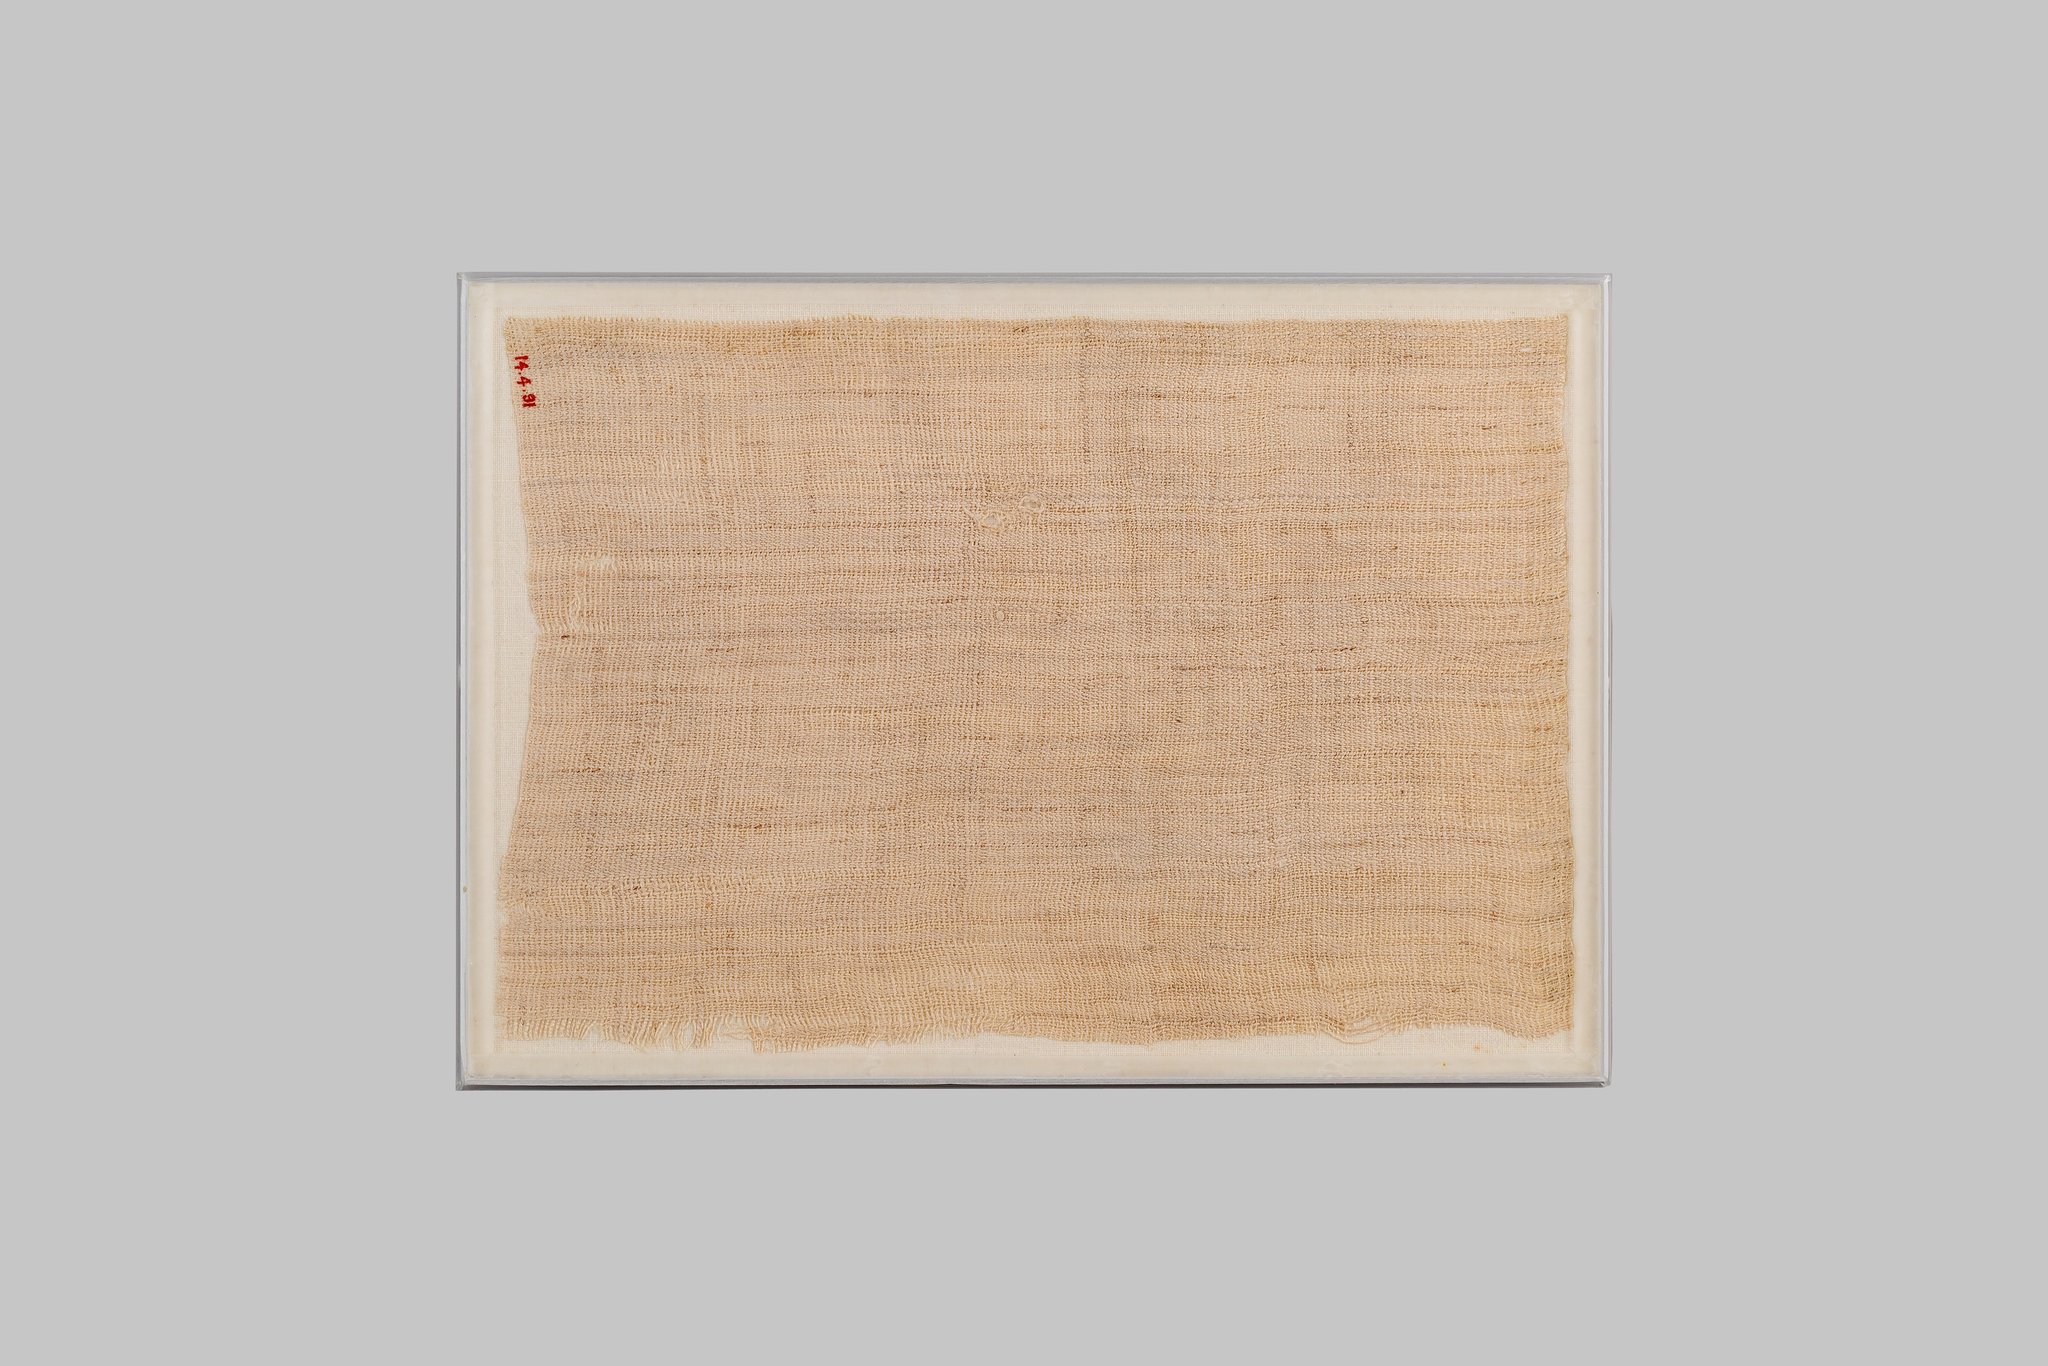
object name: linen fragment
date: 2880-2465 BCE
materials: linen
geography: egypt